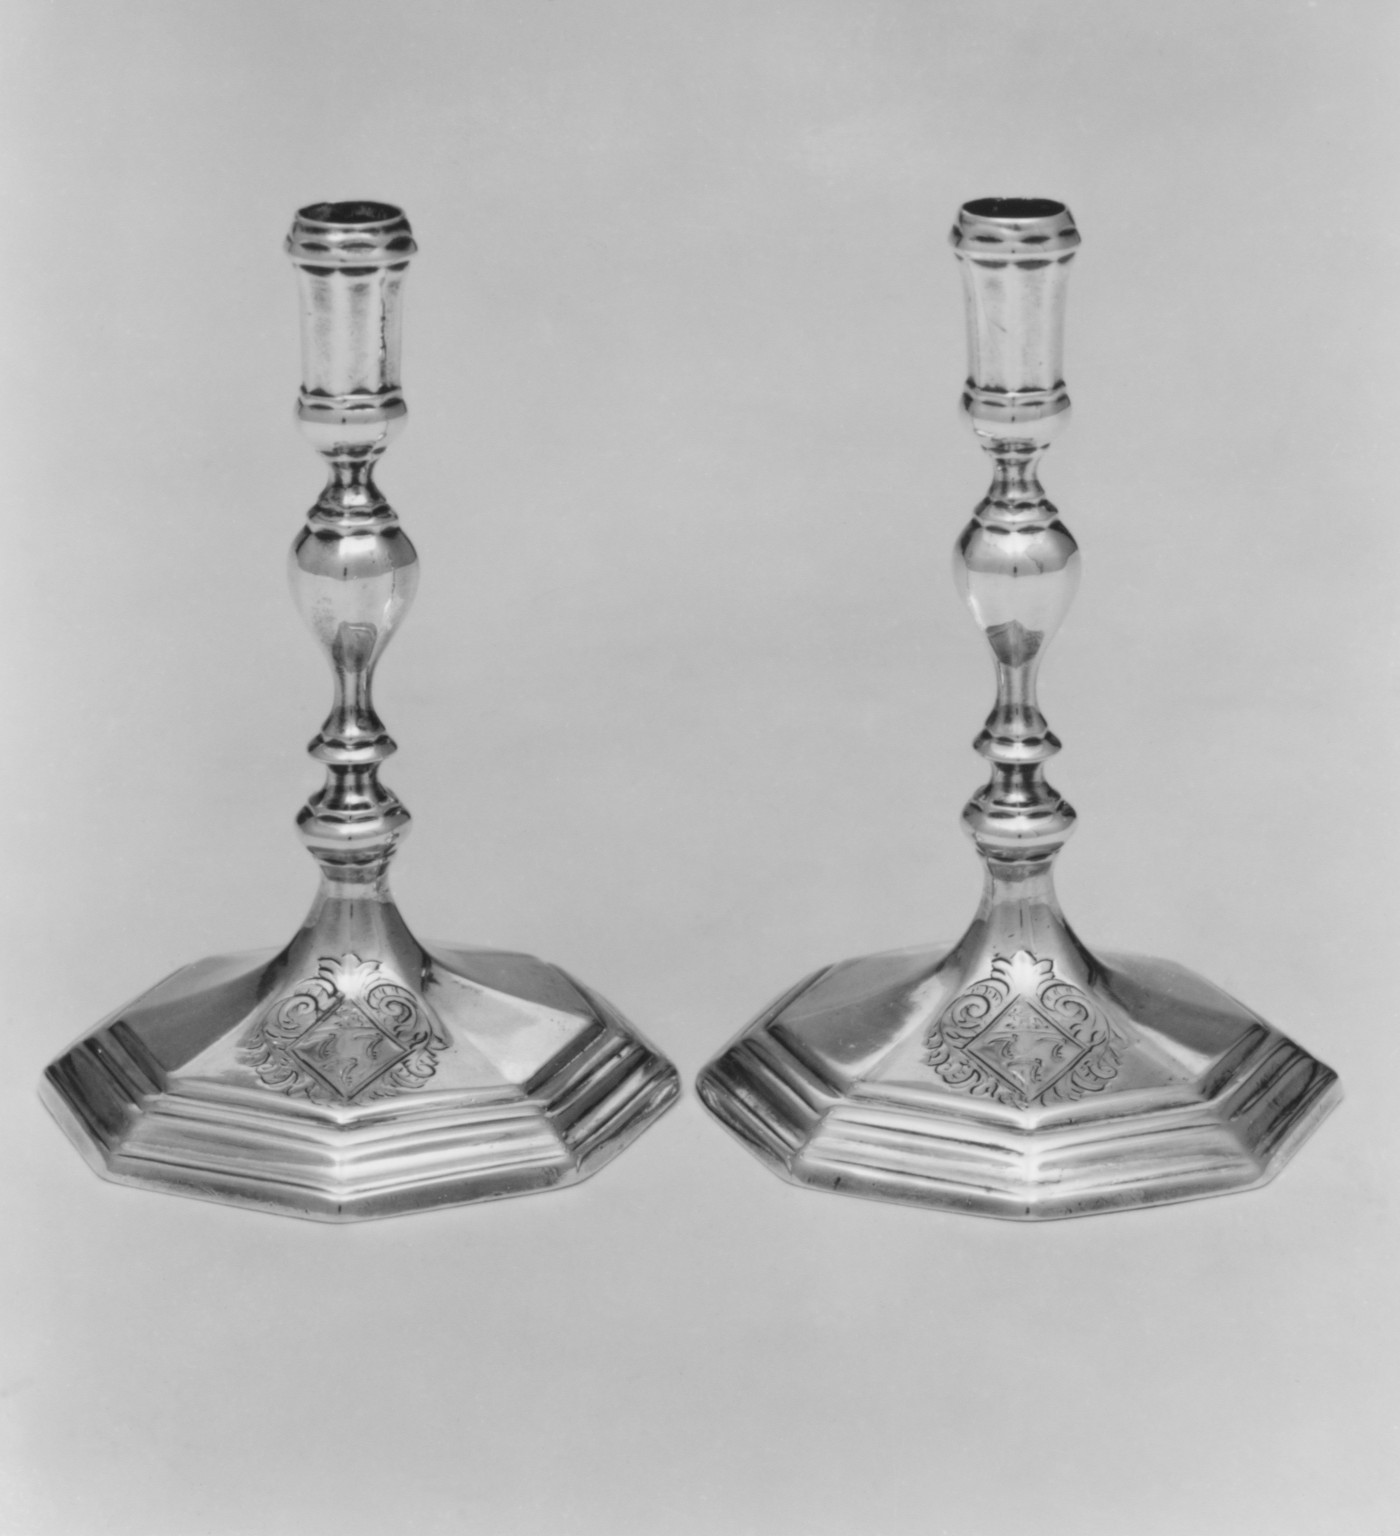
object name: taperstick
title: Pair of tapersticks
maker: thomas merry i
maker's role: maker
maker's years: 1701-1724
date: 1710-1711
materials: silver